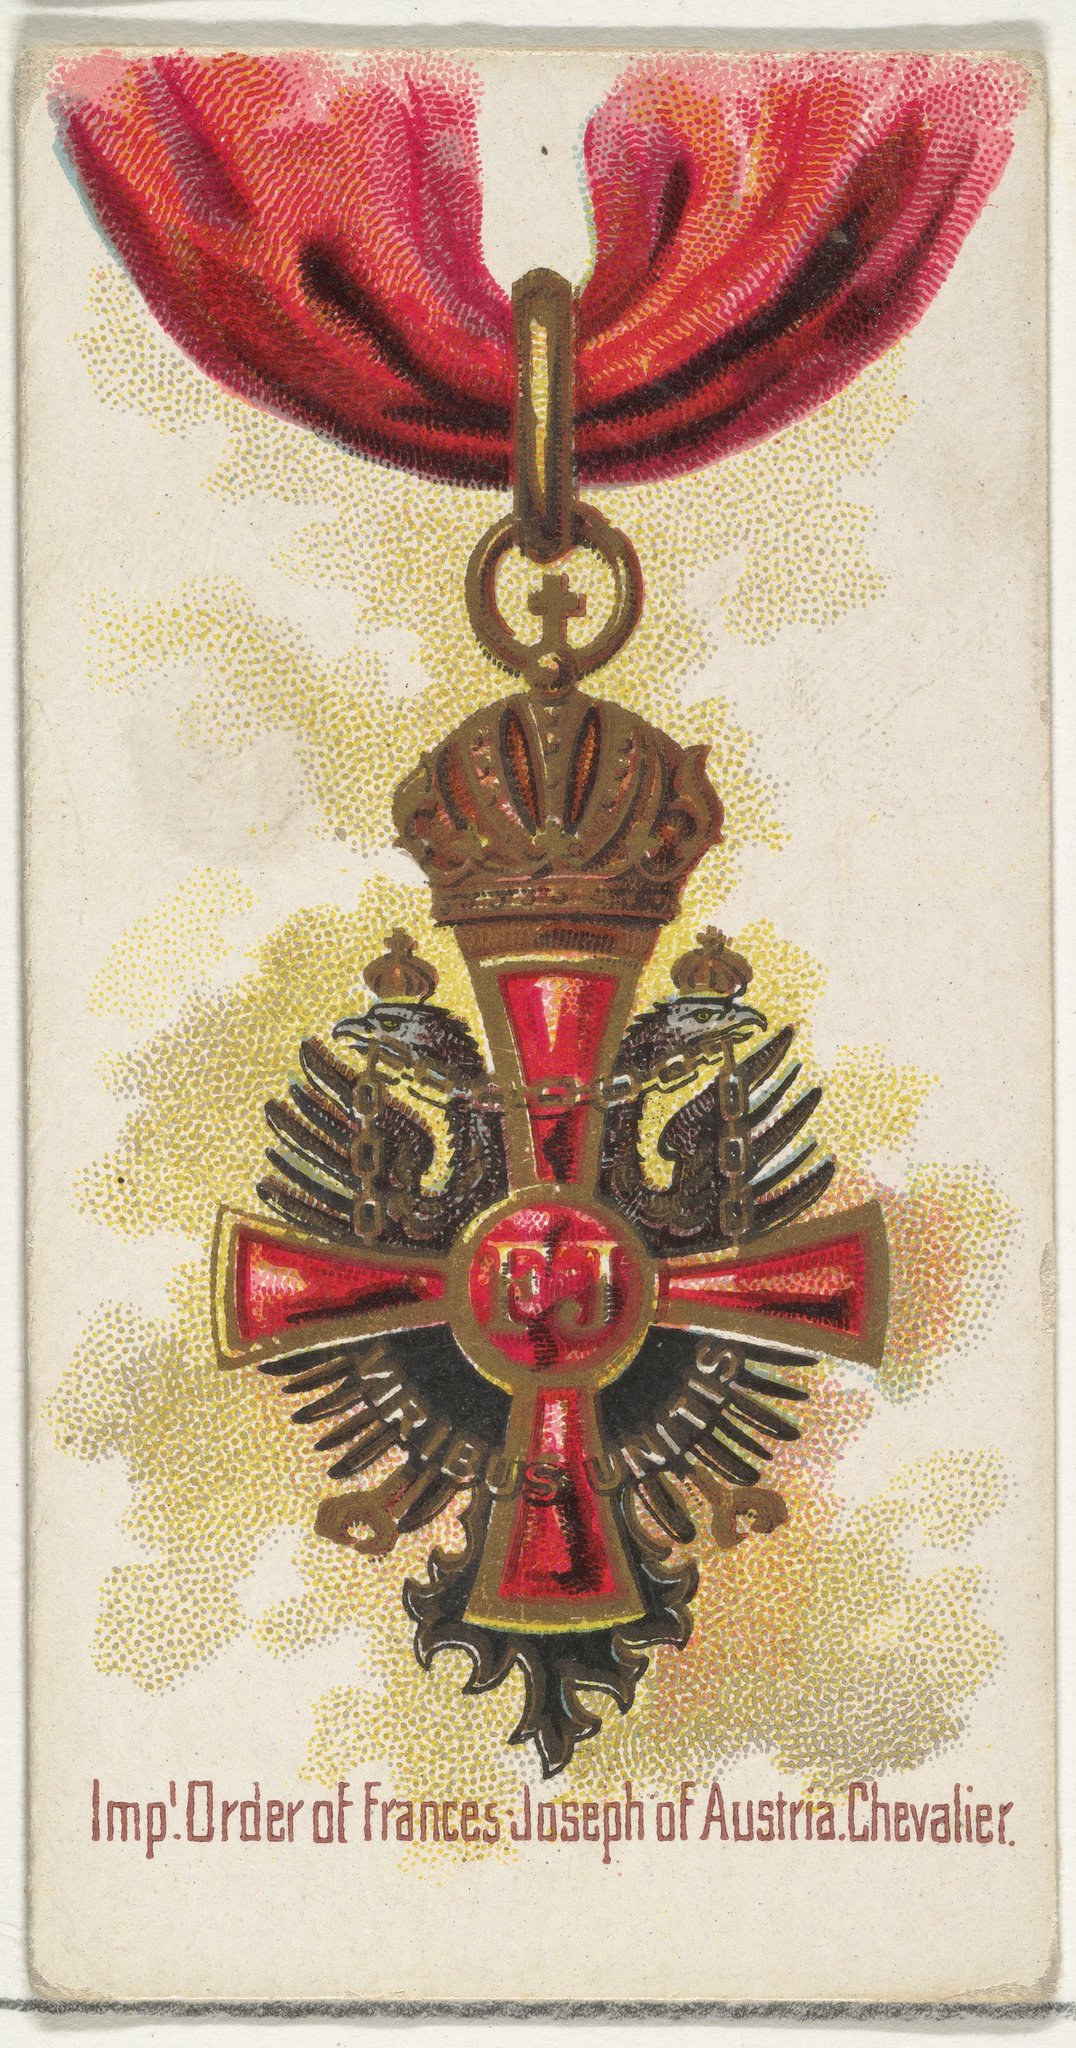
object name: print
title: Imperial Order of Frances Joseph of Austria, Chevalier, from the World's Decorations series (N30) for Allen & Ginter Cigarettes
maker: allen & ginter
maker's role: publisher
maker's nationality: american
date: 1890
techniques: color lithograph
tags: medals